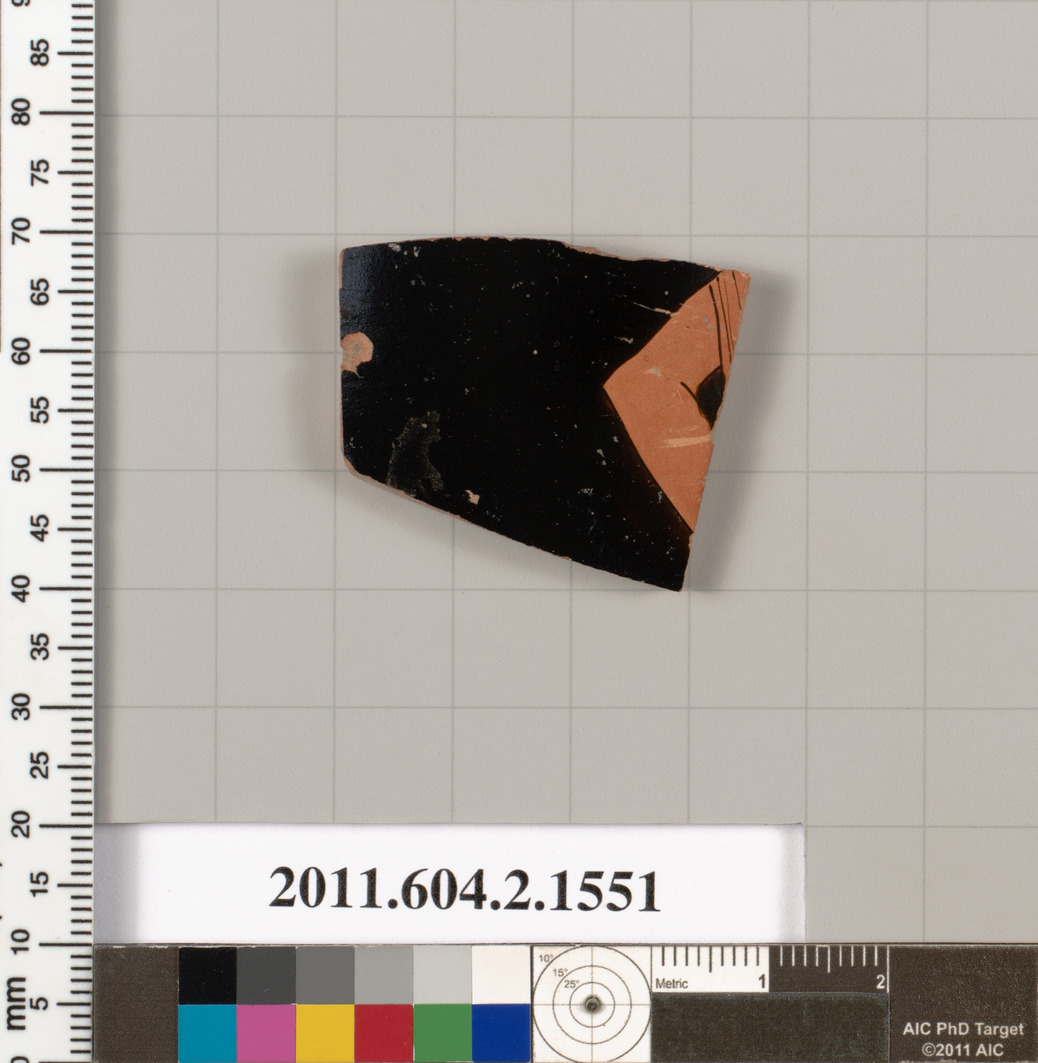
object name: skyphos fragment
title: Terracotta fragment of a skyphos (deep drinking cup)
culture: greek, attic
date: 460-440 BCE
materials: terracotta